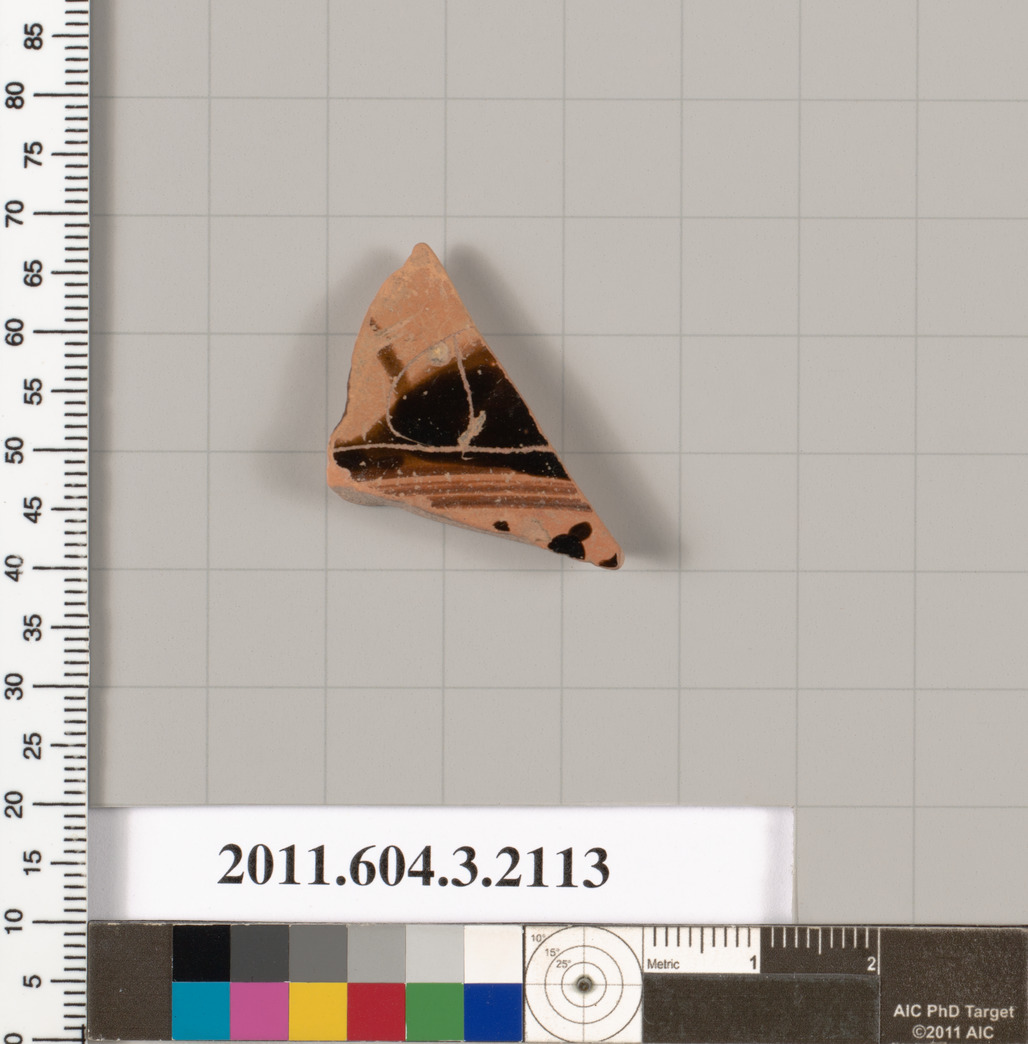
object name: kylix fragment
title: Terracotta fragment of a kylix (drinking cup)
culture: greek, attic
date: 534-468 BCE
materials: terracotta